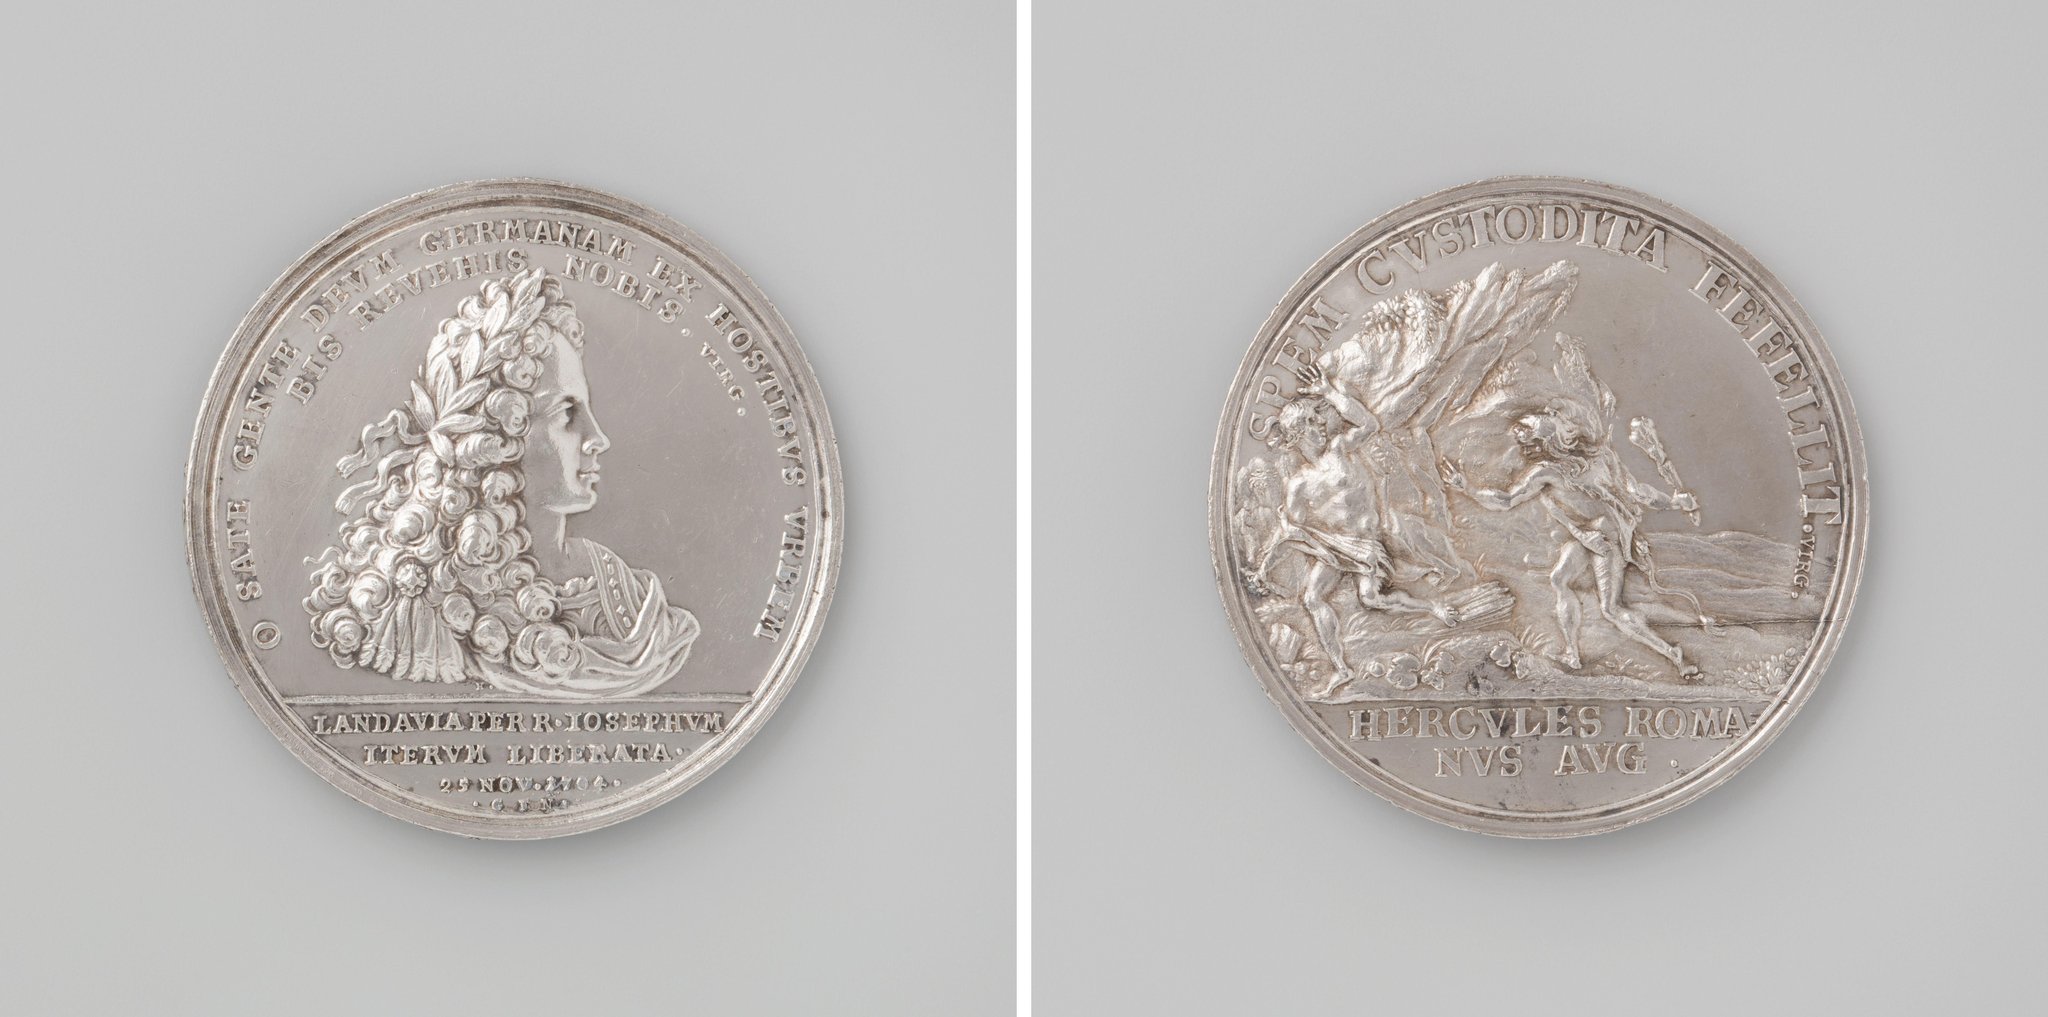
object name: history medal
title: Landau opnieuw door Jozef I ingenomen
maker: georg friedrich nuernberger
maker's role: medailleur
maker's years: 1677-1721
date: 1704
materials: silver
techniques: striking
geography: nuremberg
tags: vienna, jozef i (duits keizer)